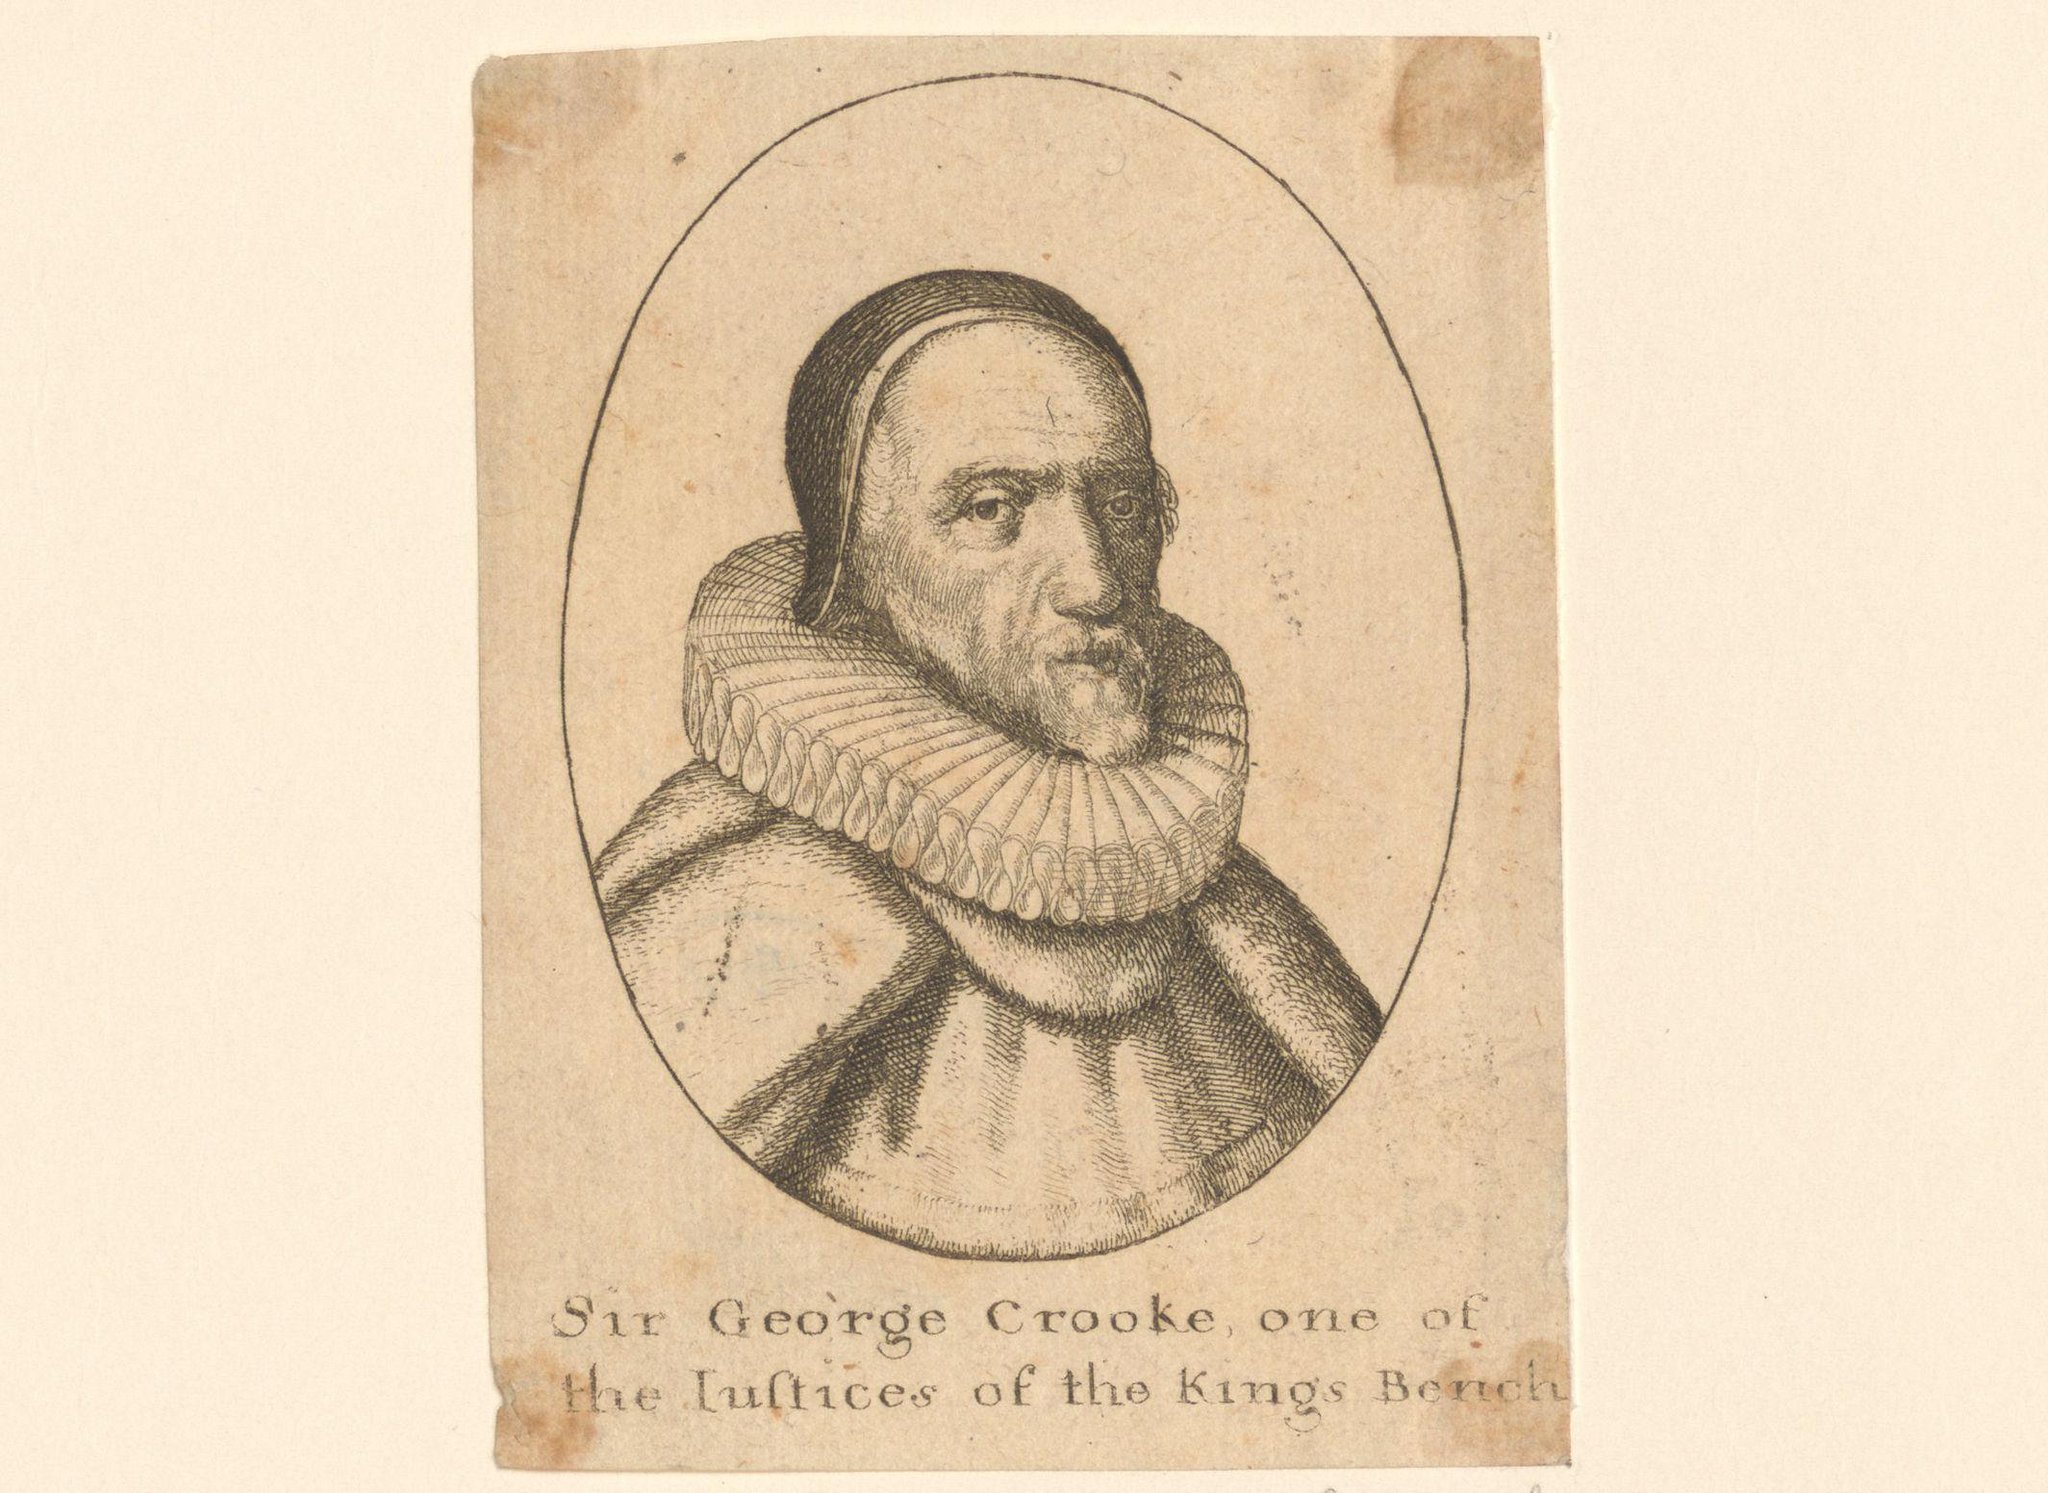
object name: print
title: Portret van George Croke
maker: wenceslaus hollar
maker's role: draughtsman, print maker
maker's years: 1607-1677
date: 1617-1677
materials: paper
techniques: etching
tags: historical persons